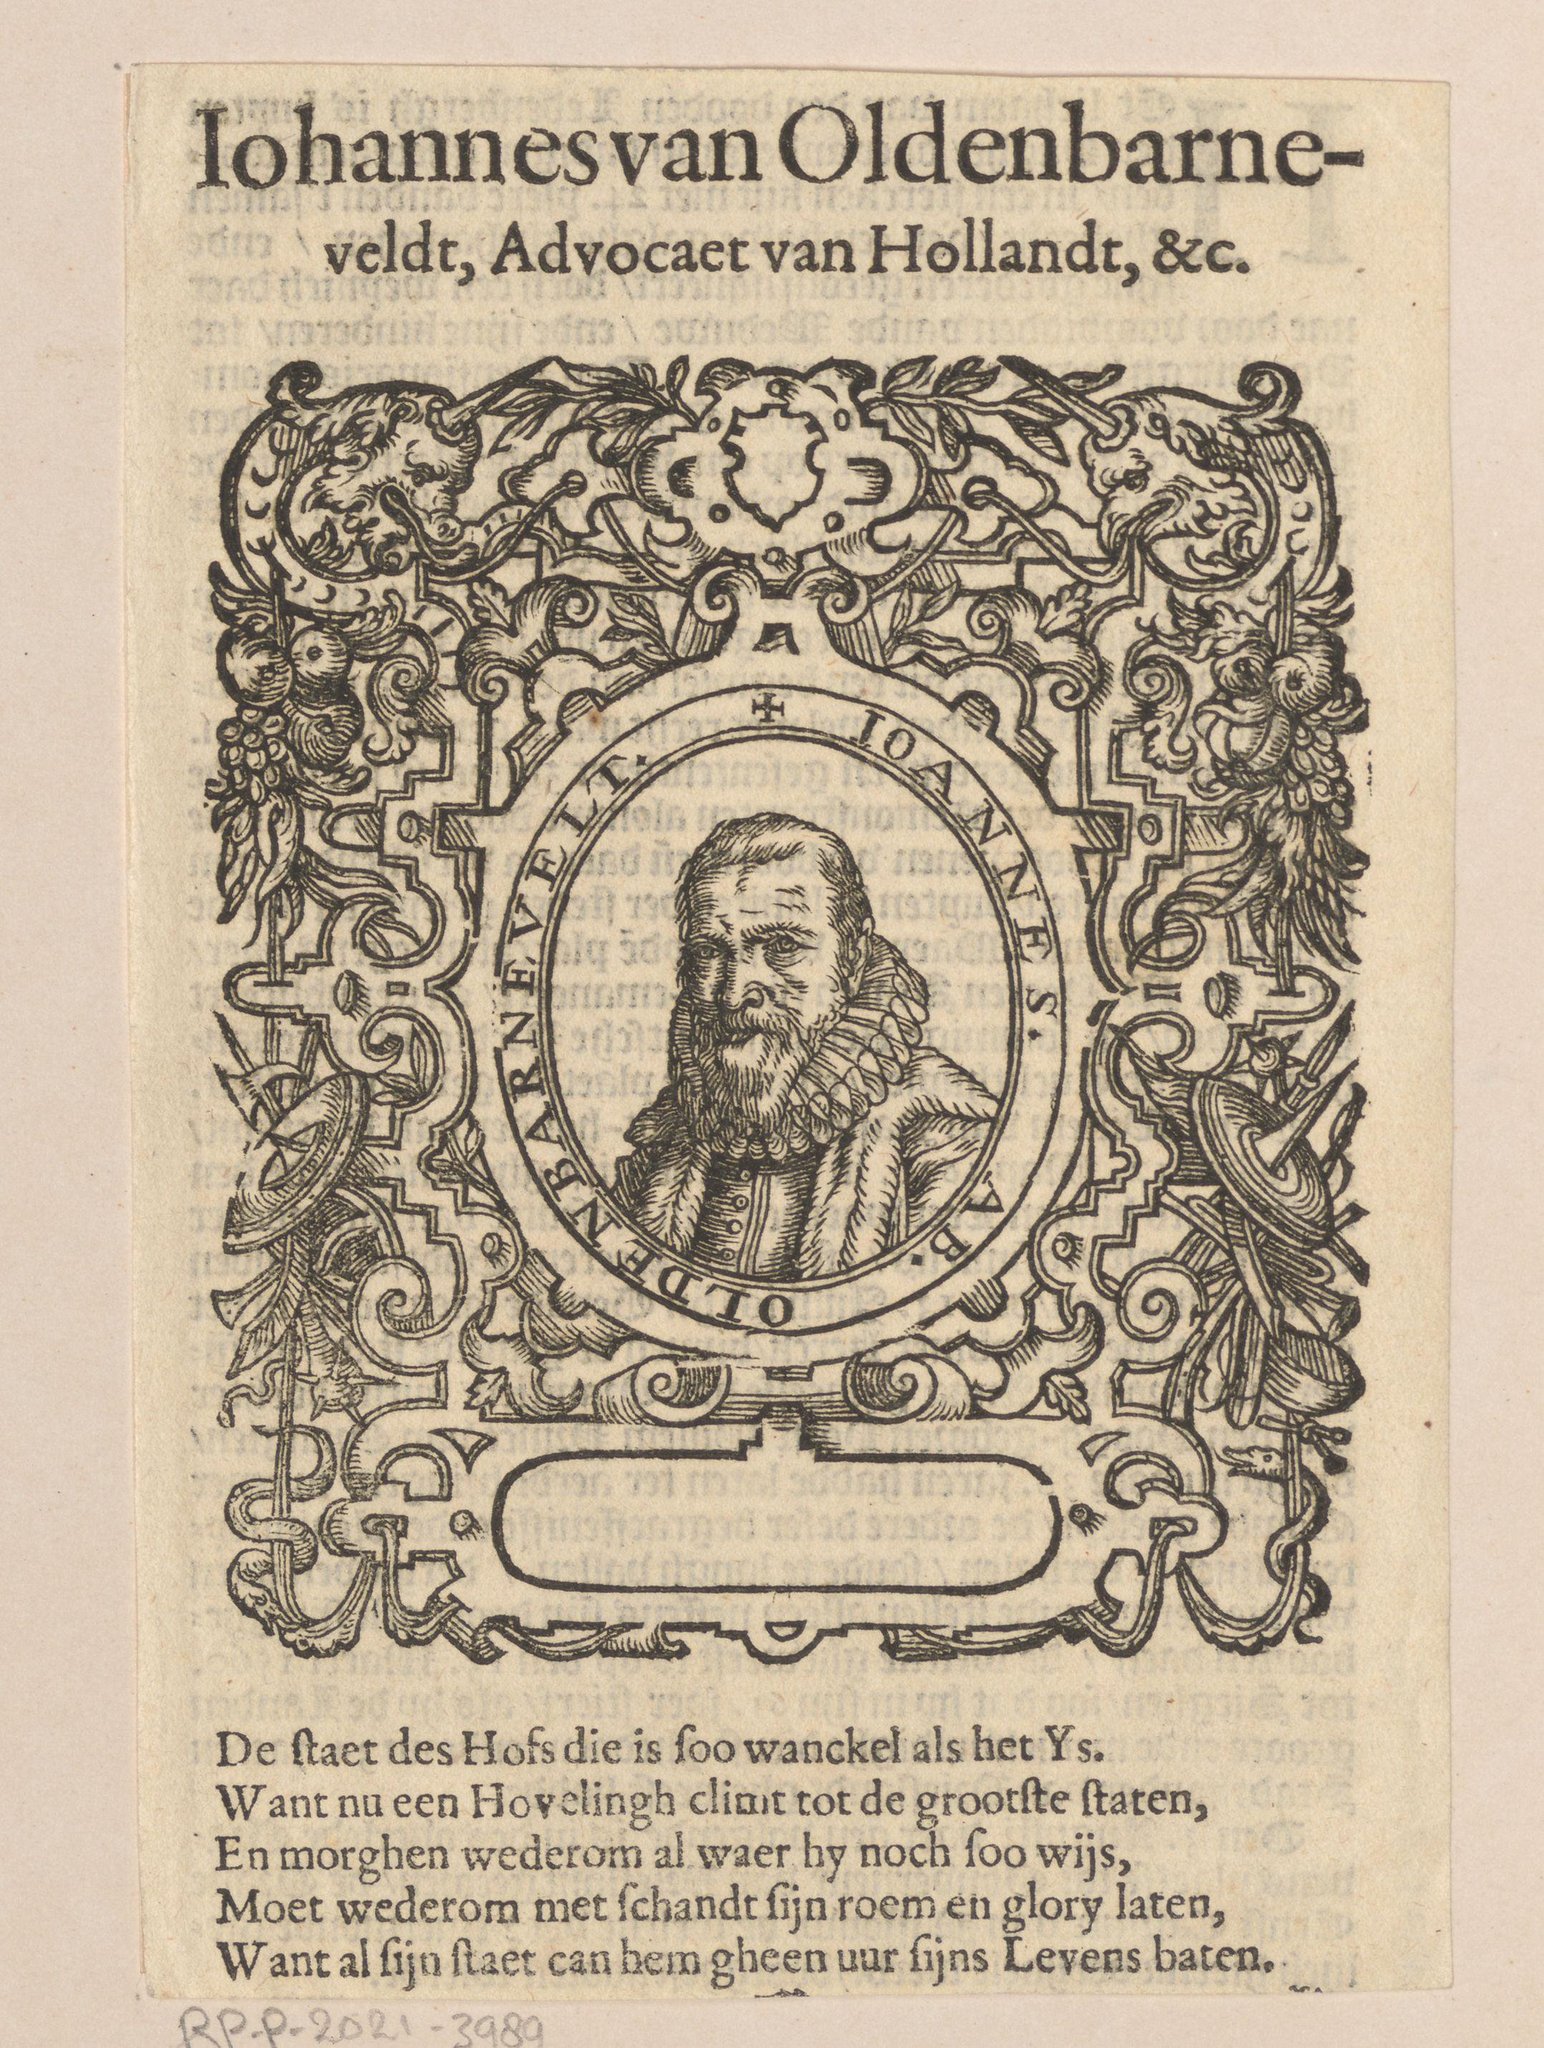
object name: book illustration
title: Portret van Johan van Oldenbarnevelt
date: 1612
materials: paper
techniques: letterpress printing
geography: arnhem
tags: the hague, johan van oldenbarnevelt, historical persons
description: Prent uit: Scriverius, Petrus. Beschrijvinghe van out Batavien, met de antiquiteyten (...). Arnhem: Jan Janssoon, 1612.